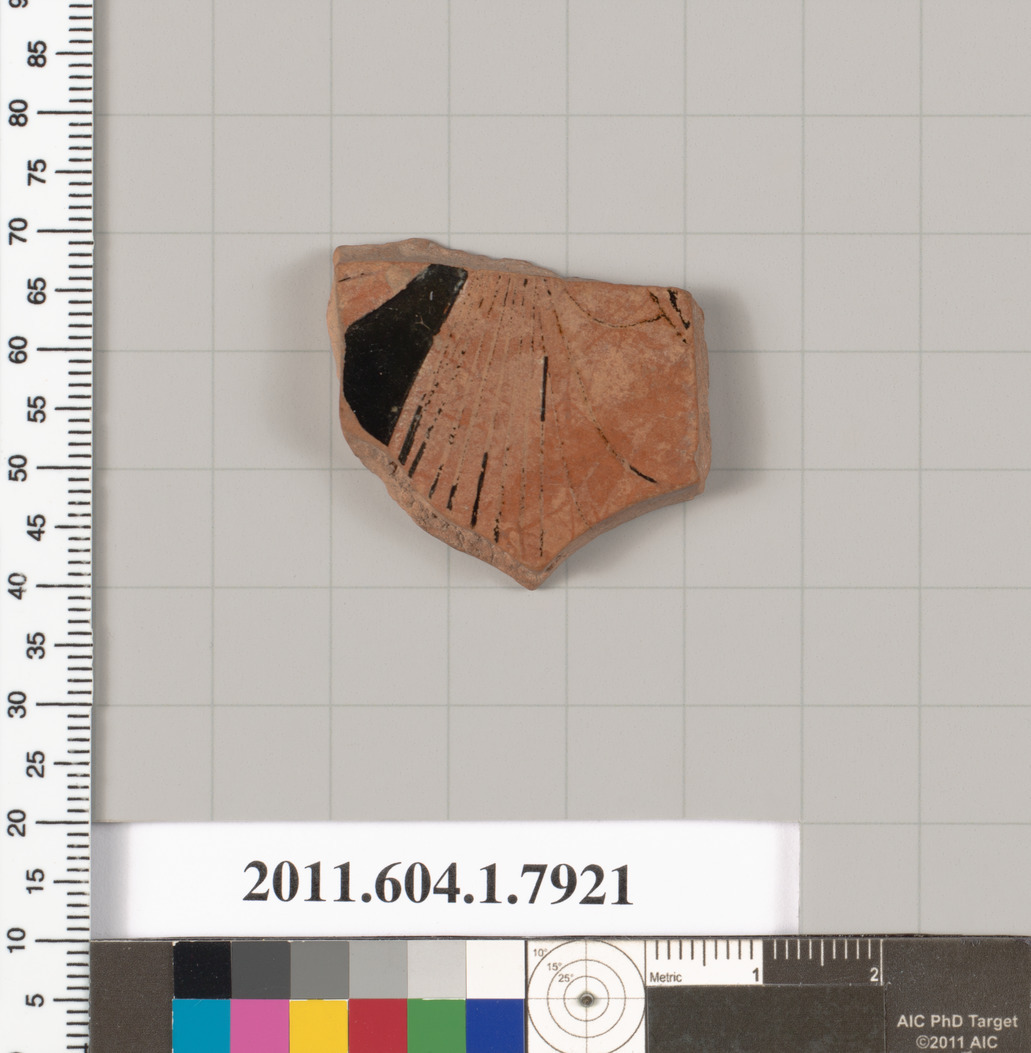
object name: kylix fragment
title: Terracotta fragment of a kylix (drinking cup)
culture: greek, attic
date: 460-450 BCE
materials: terracotta